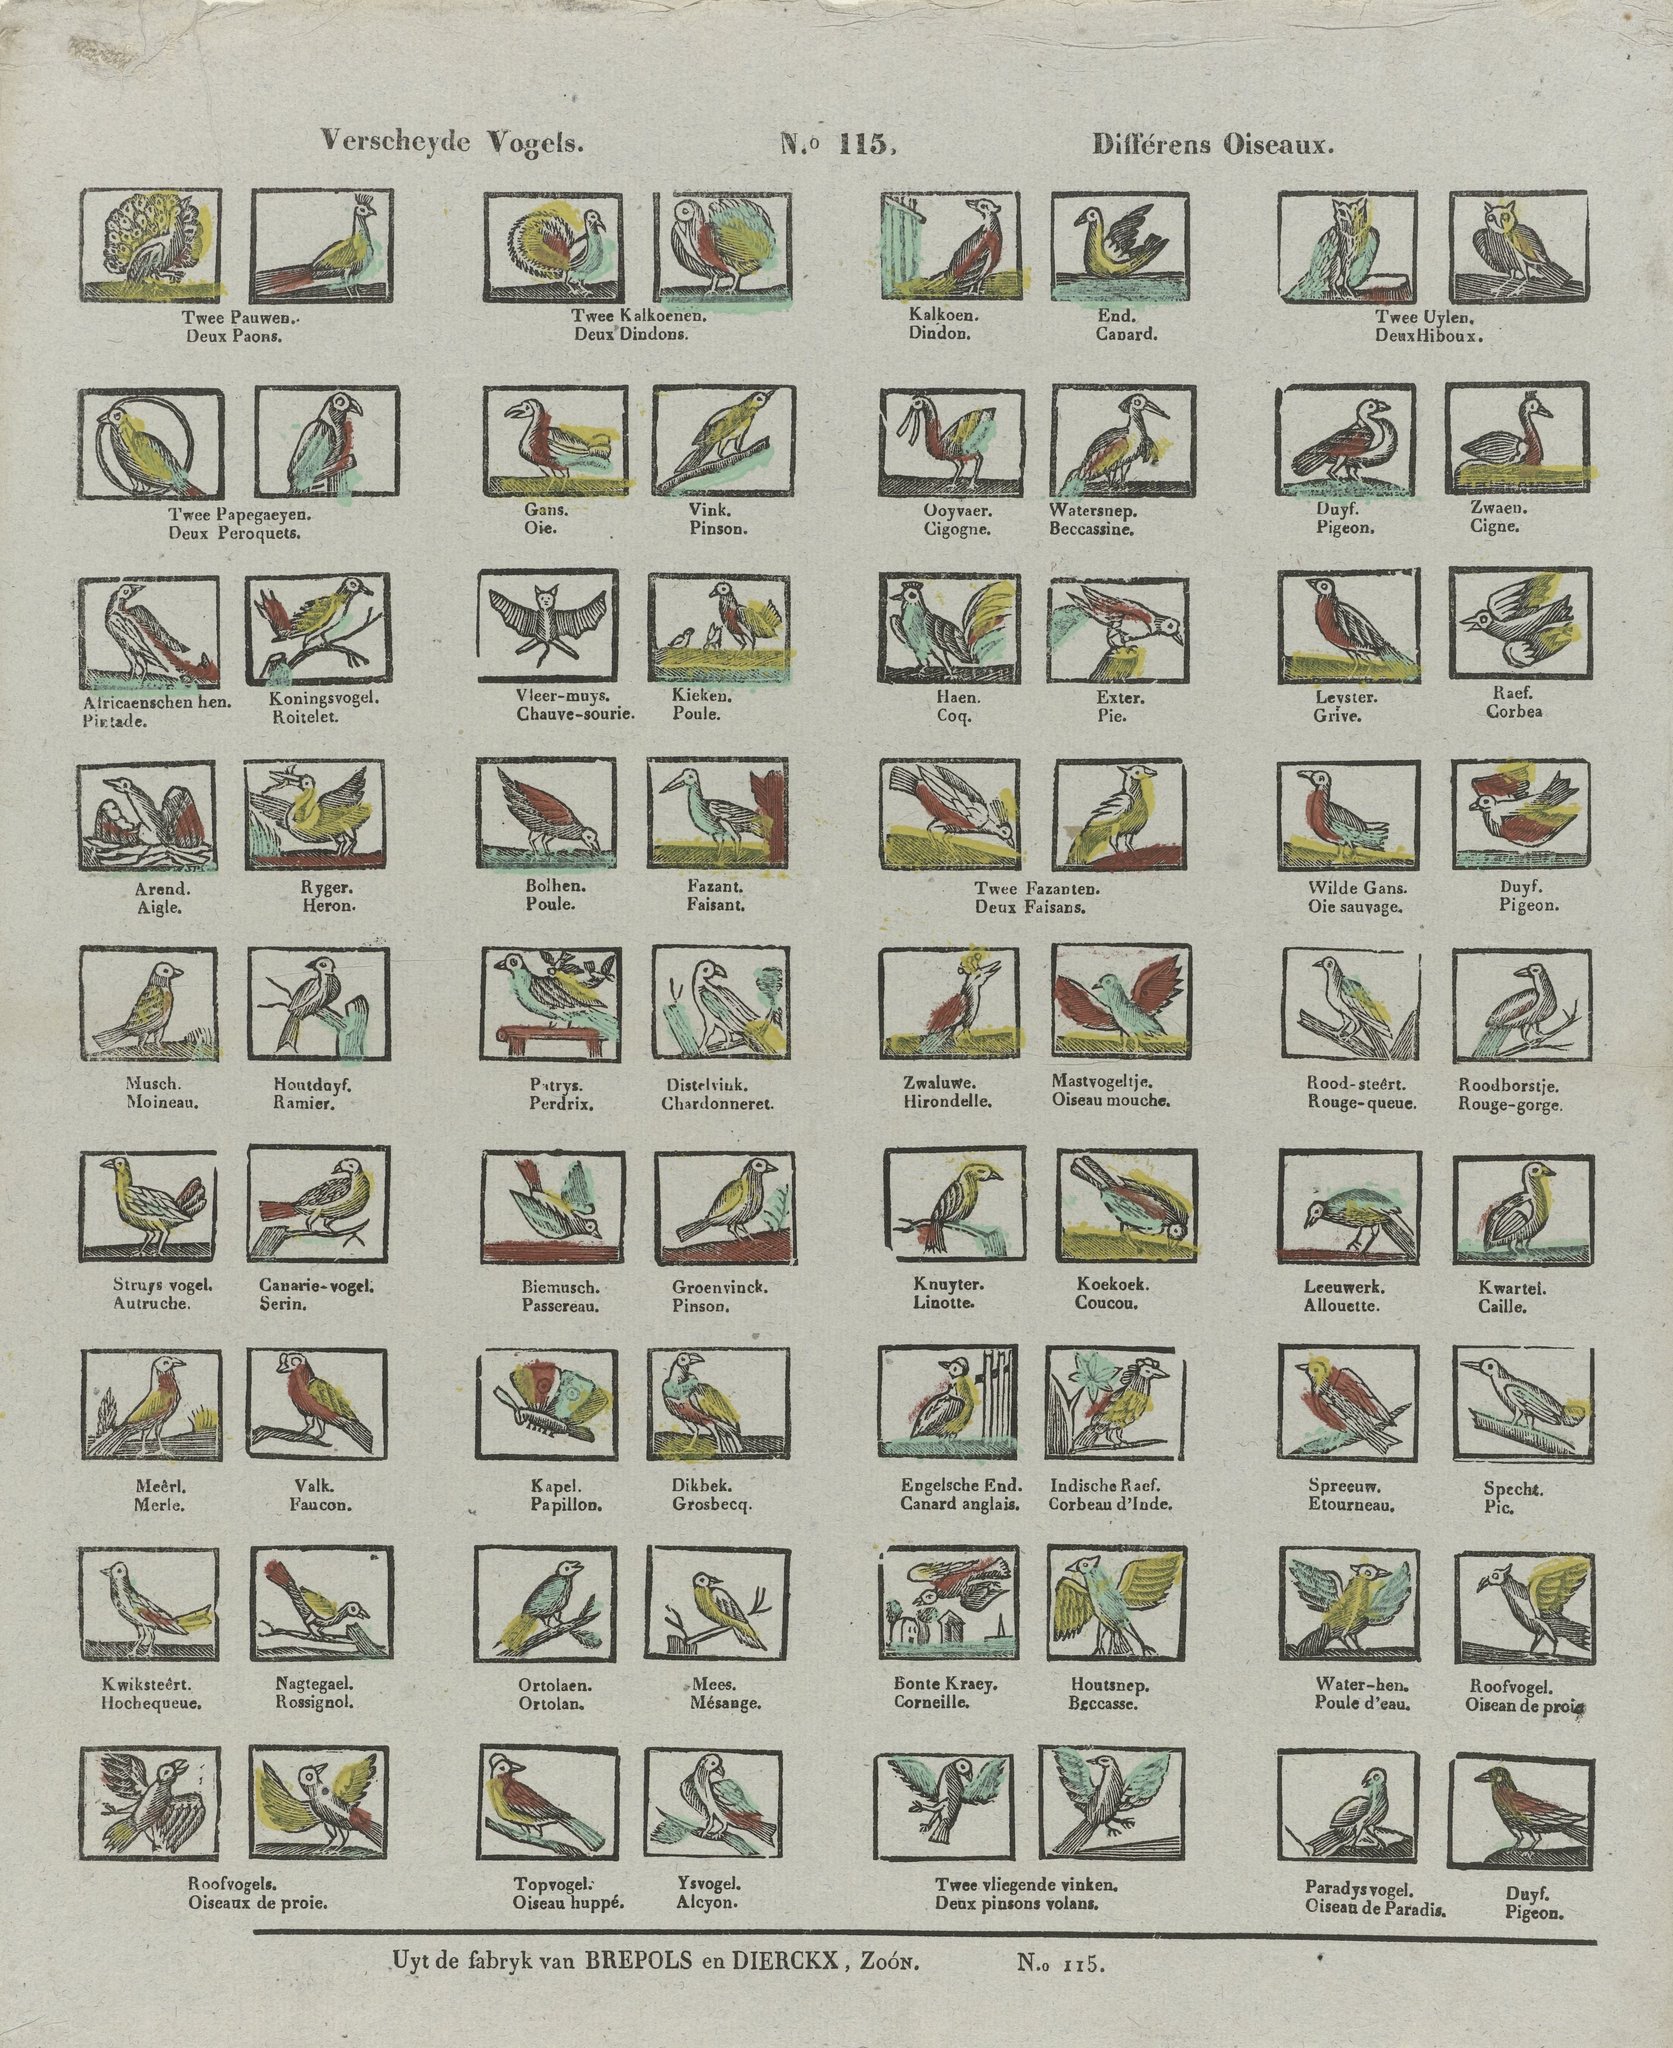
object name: popular print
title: Verscheyde vogels / Différens oiseaux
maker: Anonymous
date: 1833-1911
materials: paper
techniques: colour, letterpress printing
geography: turnhout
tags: birds, insects: butterfly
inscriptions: collector's mark: Lugt 2760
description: Blad met 72 voorstellingen van vogels en een vlinder. Onder elke voorstelling de naam van de vogel in het Nederlands en in het Frans, soms per twee vogels. Genummerd midden boven: No. 115.